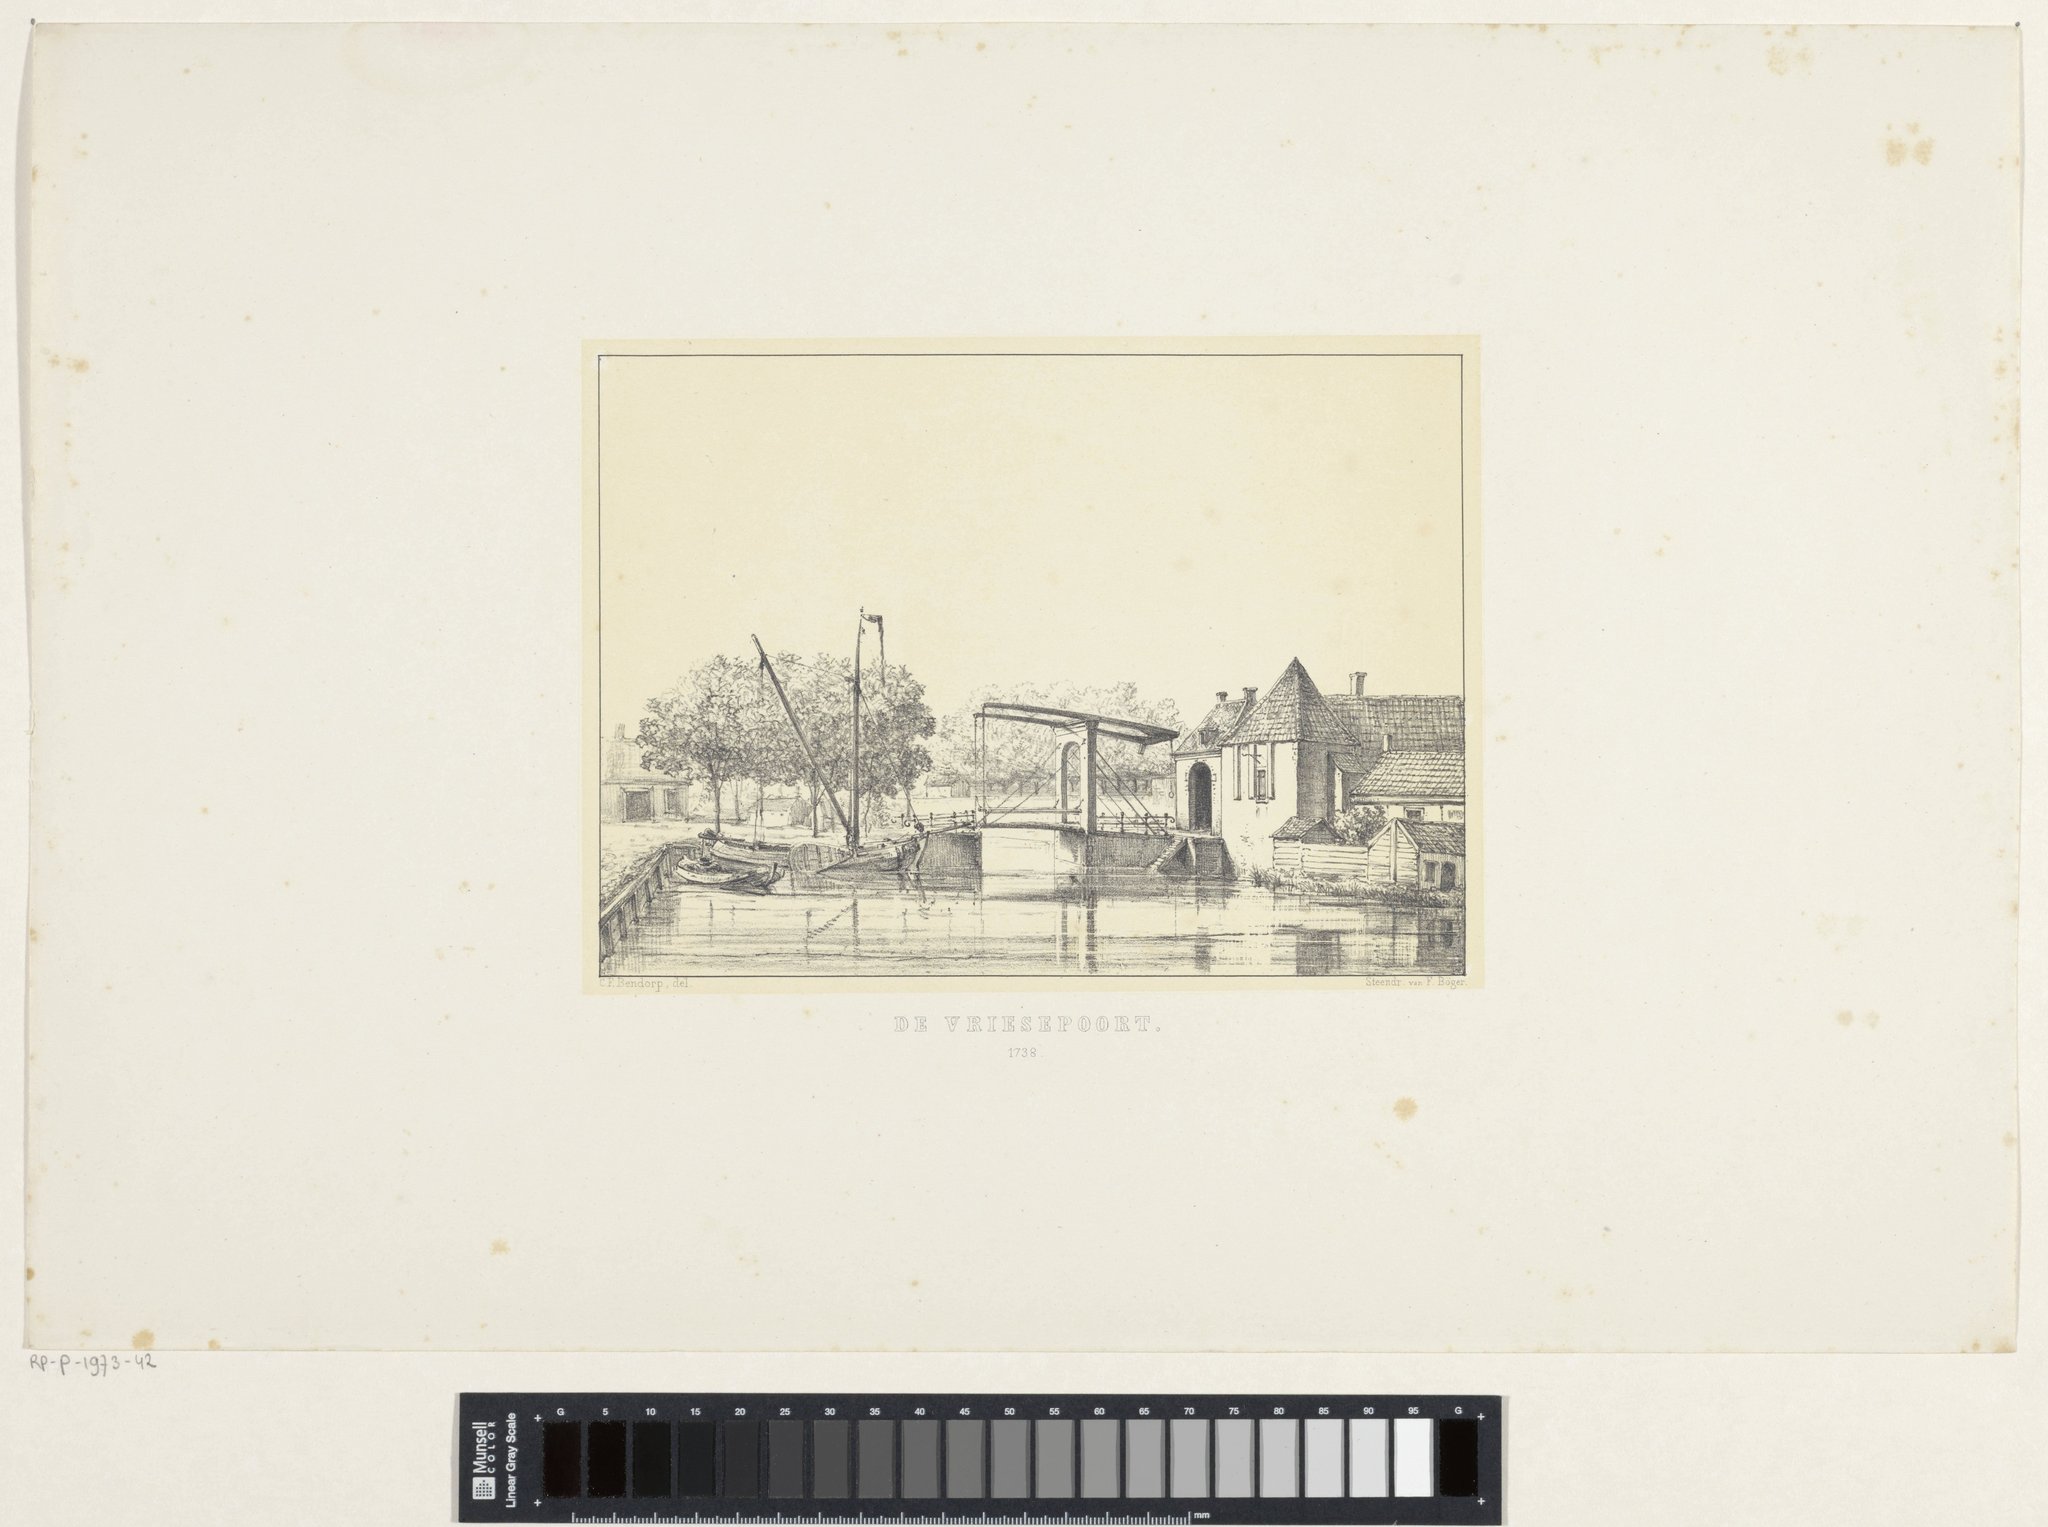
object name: print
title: De Vriesepoort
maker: carel frederik bendorp (ii)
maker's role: draughtsman, painter, print maker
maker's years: 1819-1897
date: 1872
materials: paper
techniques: tone lithography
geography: dordrecht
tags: drawbridge ~ fortified city, dordrecht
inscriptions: collector's mark: Lugt 2760, collector's mark: Lugt 2228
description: In het midden een houten ophaalbrug, rechts daarvan de poort naar de stad. Links van de brug liggen enkele boten in het water. Onder de afbeelding het jaartal 1738.